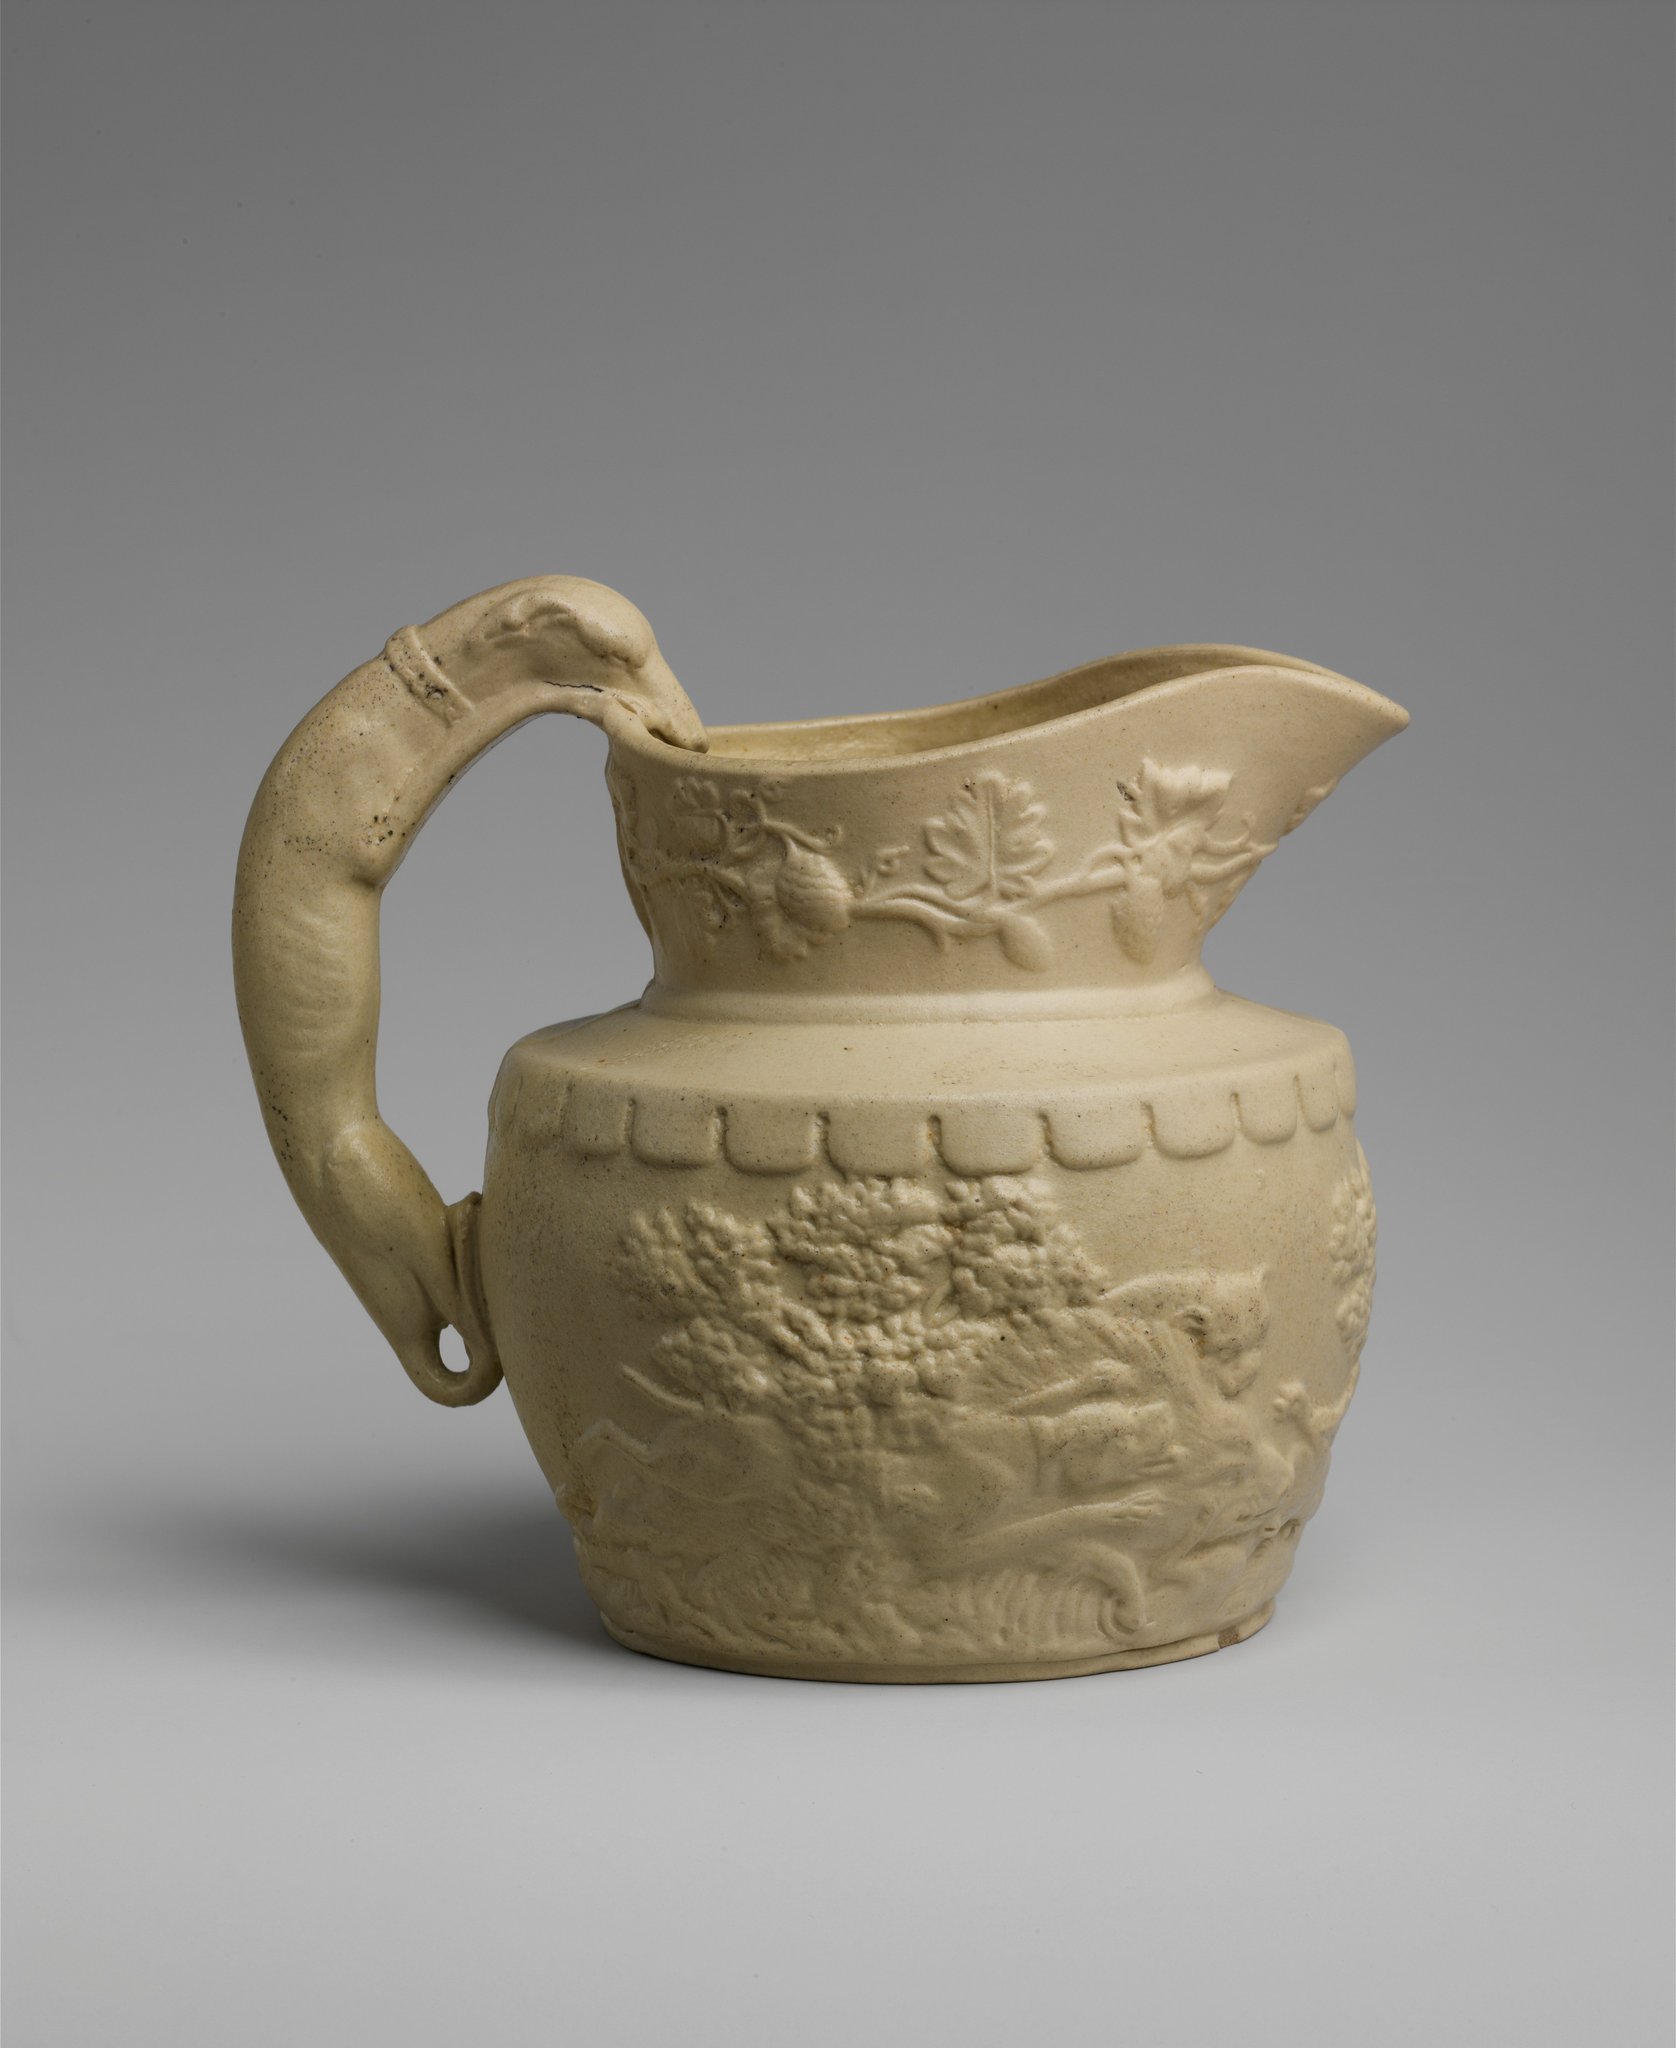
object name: pitcher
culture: american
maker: daniel greatbatch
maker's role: designer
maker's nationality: british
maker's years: 1838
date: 1829-1833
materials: stoneware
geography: united states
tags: boars,deer,dogs